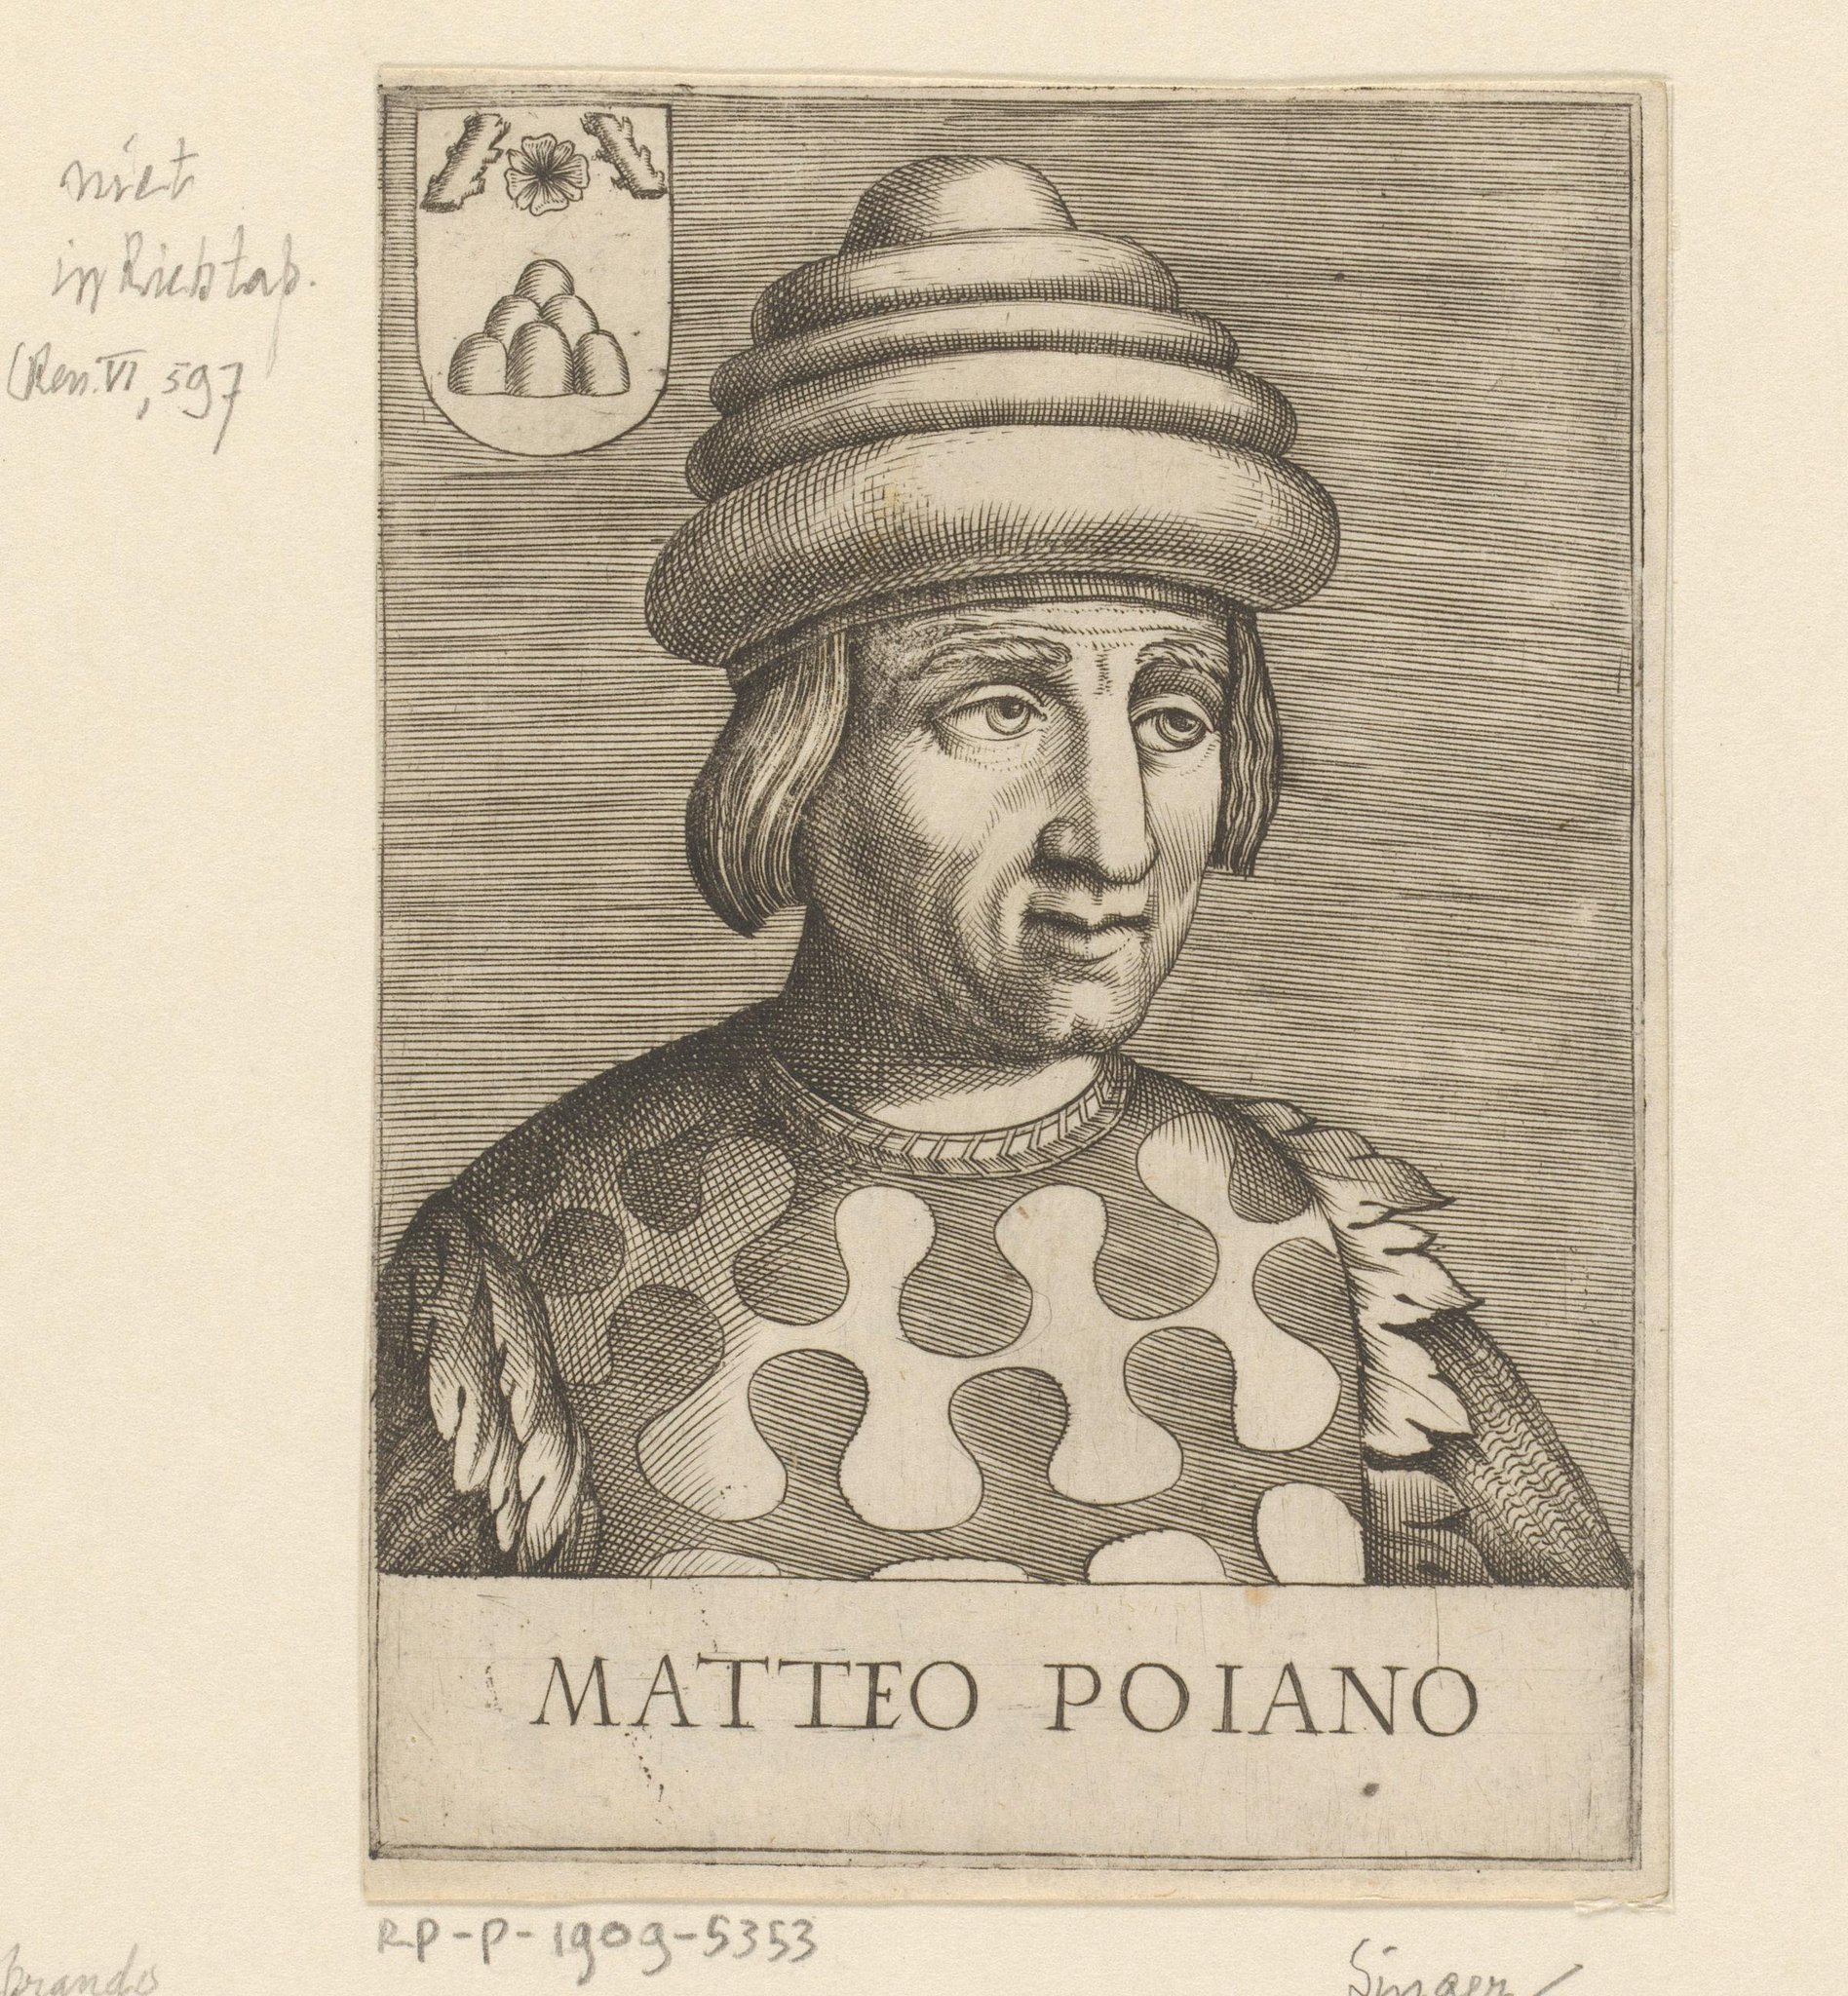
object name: print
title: Portret van Matteo Poiano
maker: Anonymous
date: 1550-1649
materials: paper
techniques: engraving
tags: historical persons, armorial bearing, heraldry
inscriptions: collector's mark: Lugt 2228